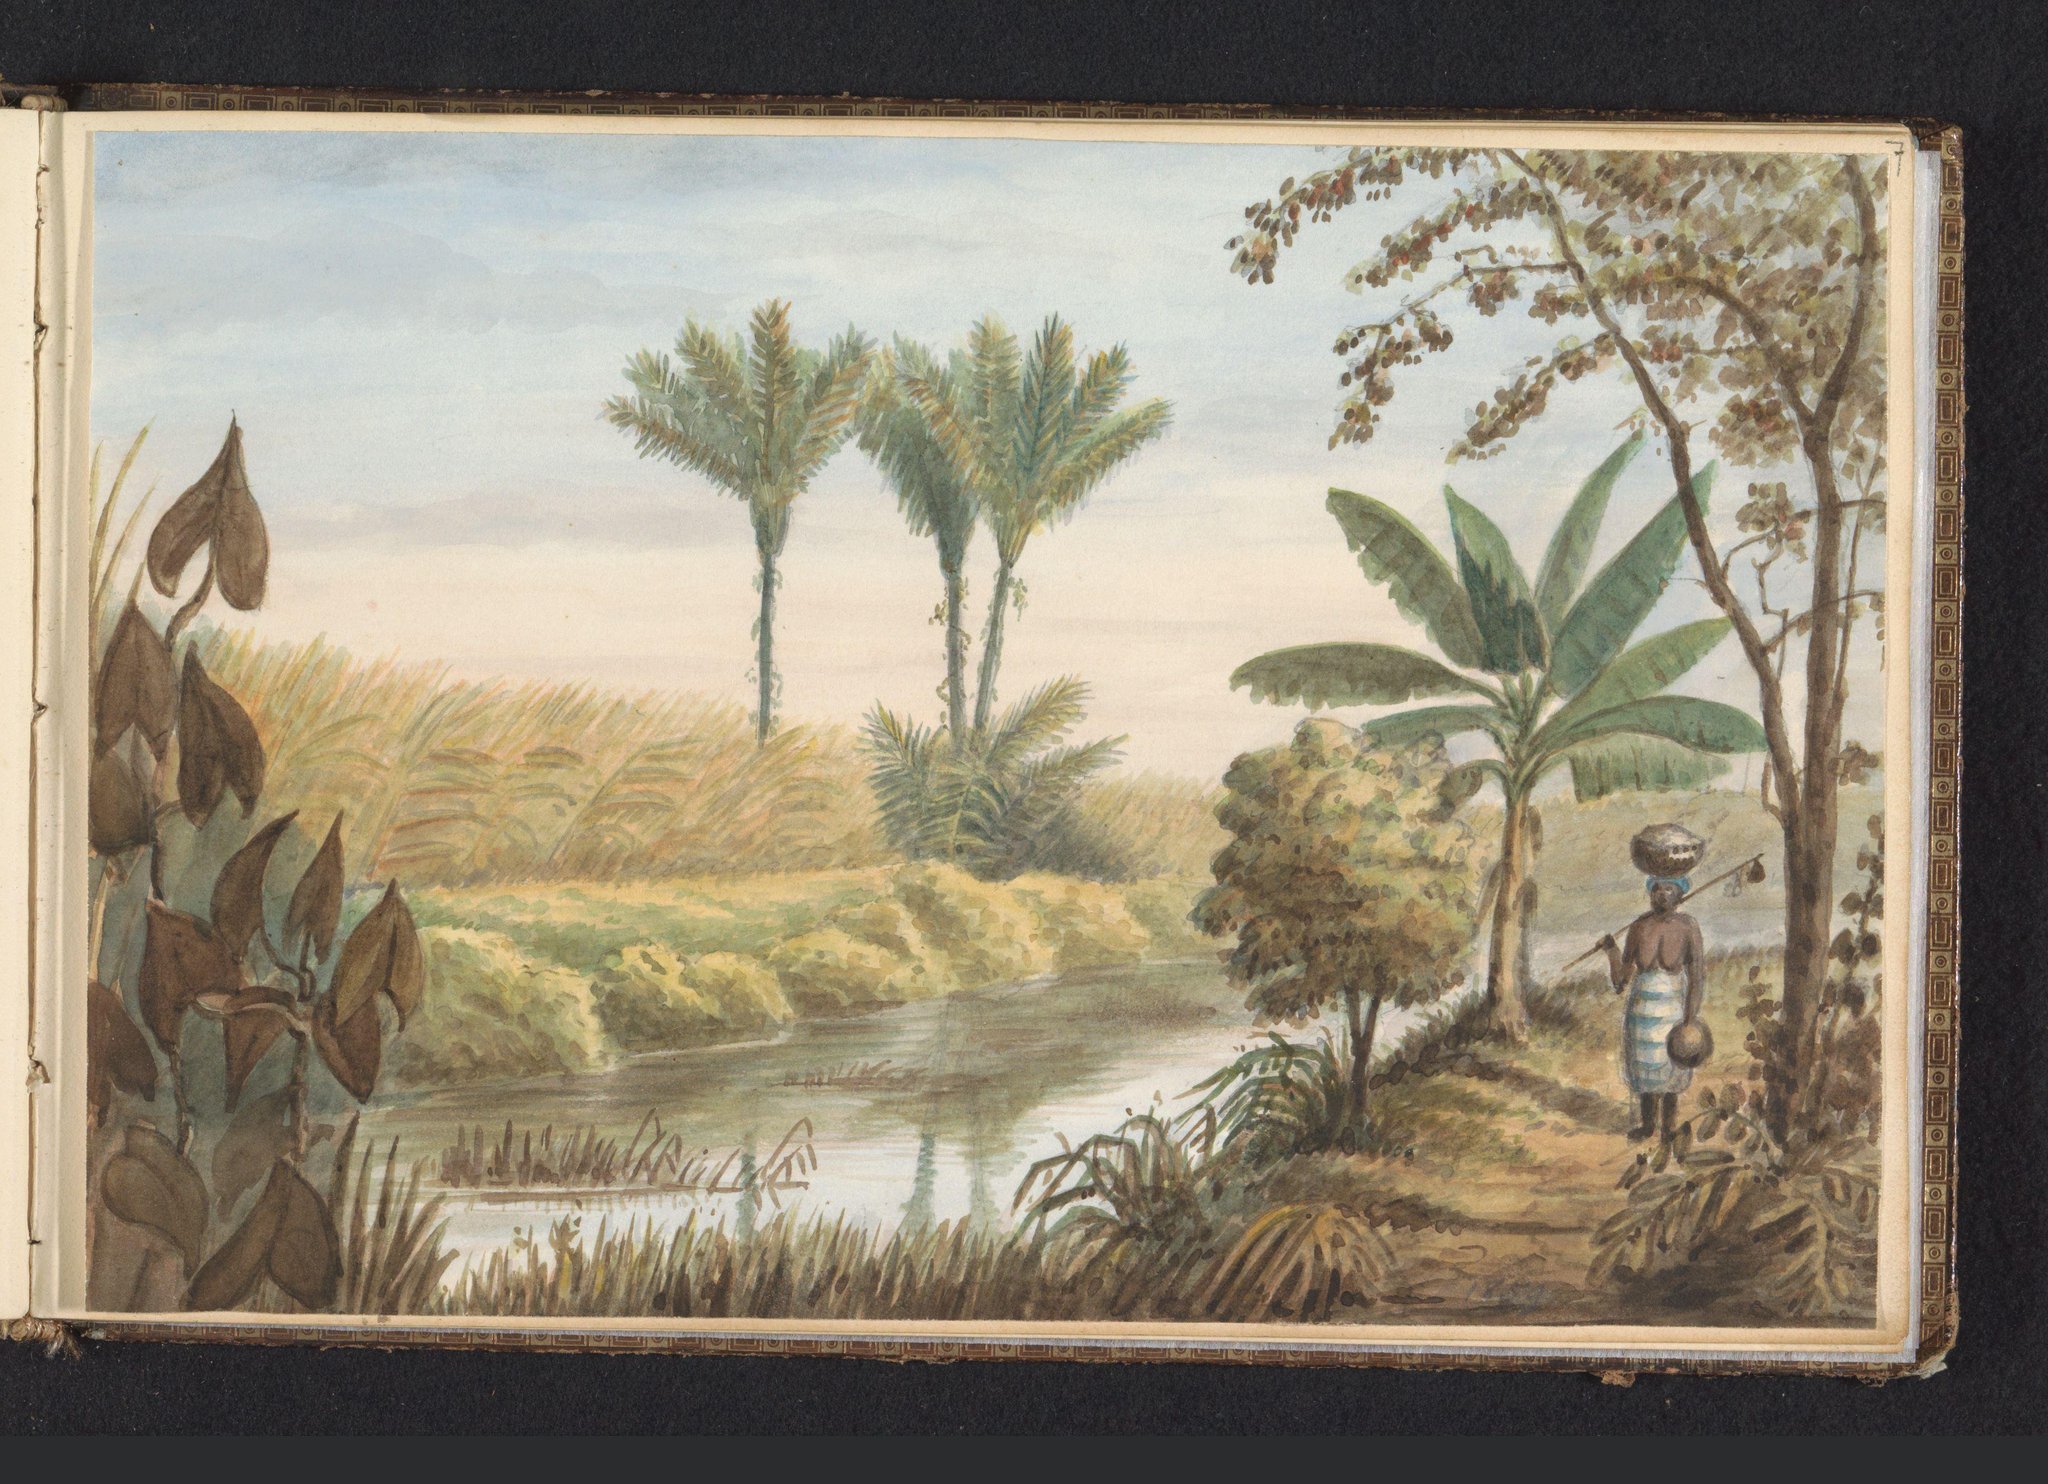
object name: album leaf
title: Veld met suikerriet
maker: jacob marius adriaan martini van geffen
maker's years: 1821-1866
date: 1859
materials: ink, paper, pencil, watercolor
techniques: brush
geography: suriname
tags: suriname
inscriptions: signature and date: ‘gedateerd recto r.o.:1859’, inscription: ‘.’